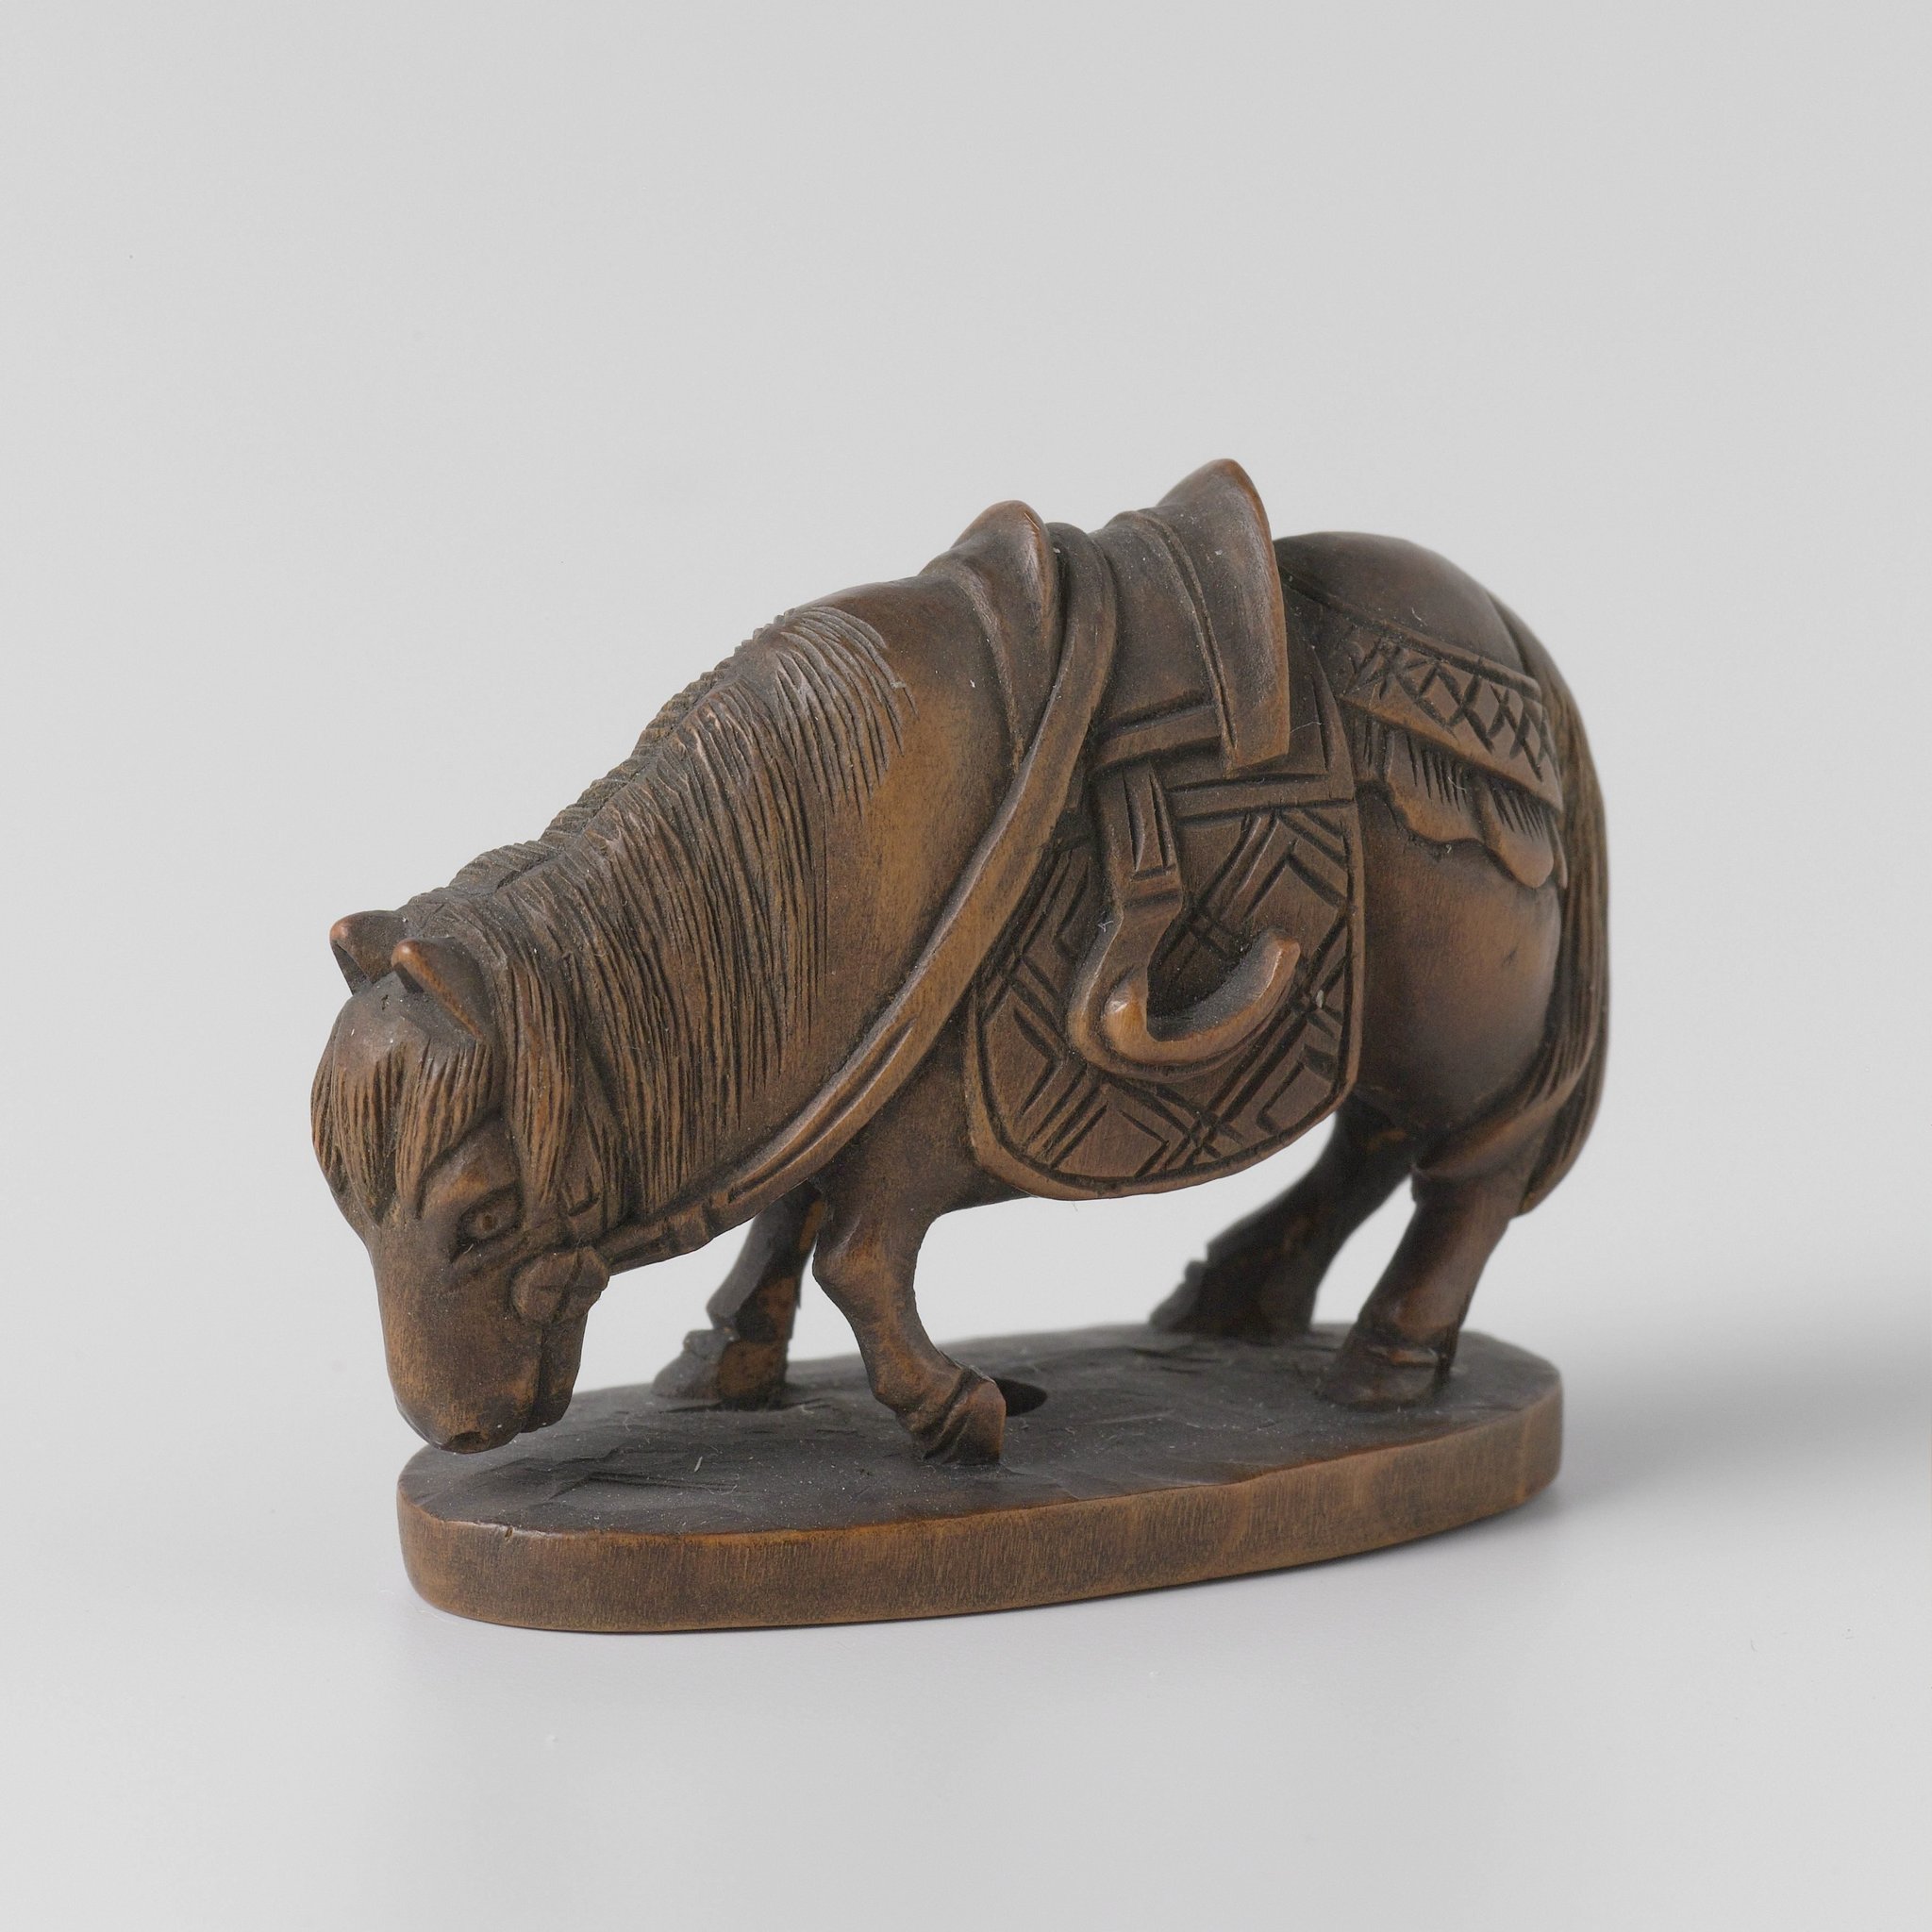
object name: netsuke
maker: Anonymous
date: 1700-1900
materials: wood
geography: japan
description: Uitbeelding van een paard/ pony die zich door de linker knie buigt. Gat door het midden van de onderkant.